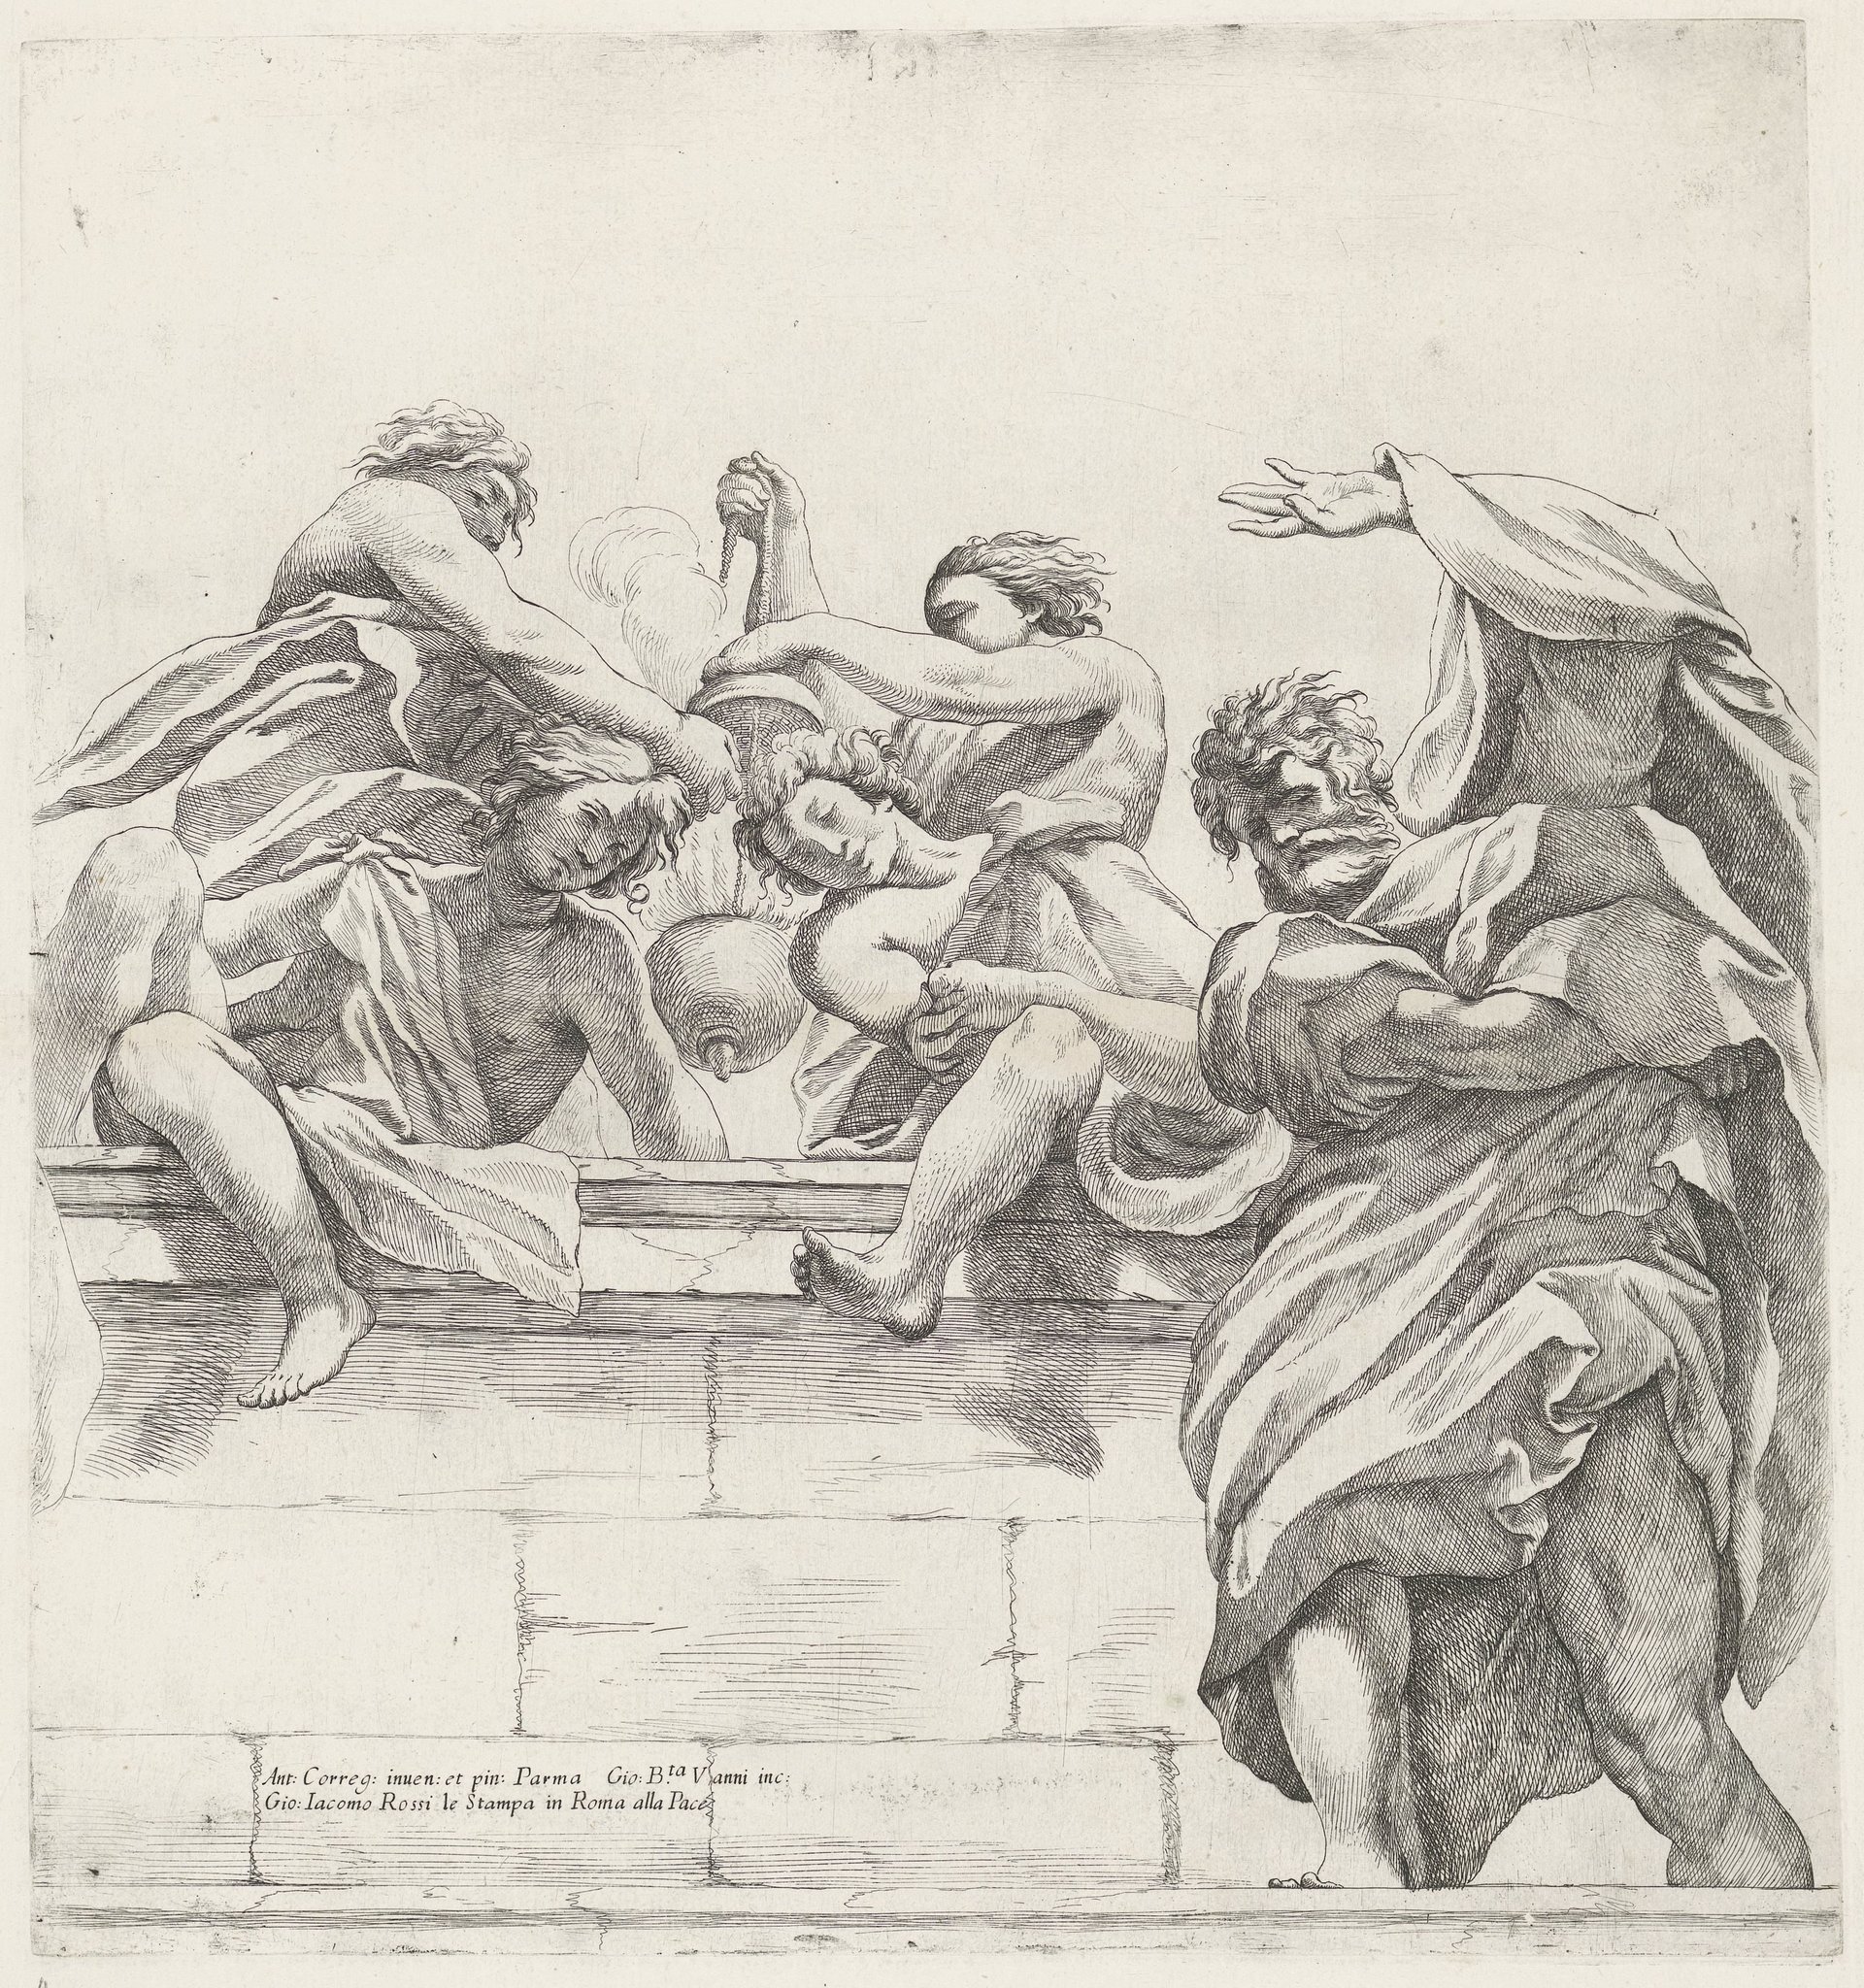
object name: print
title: Apostel en vier engelen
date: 1609-1660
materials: paper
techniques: etching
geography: parma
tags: (single) apostle, unspecified, angels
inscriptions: collector's mark: Lugt 240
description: Prent uit een reeks van 8 prenten naar de koepeldecoraties door Correggio in de S. Giovanni Evangelista in Parma.